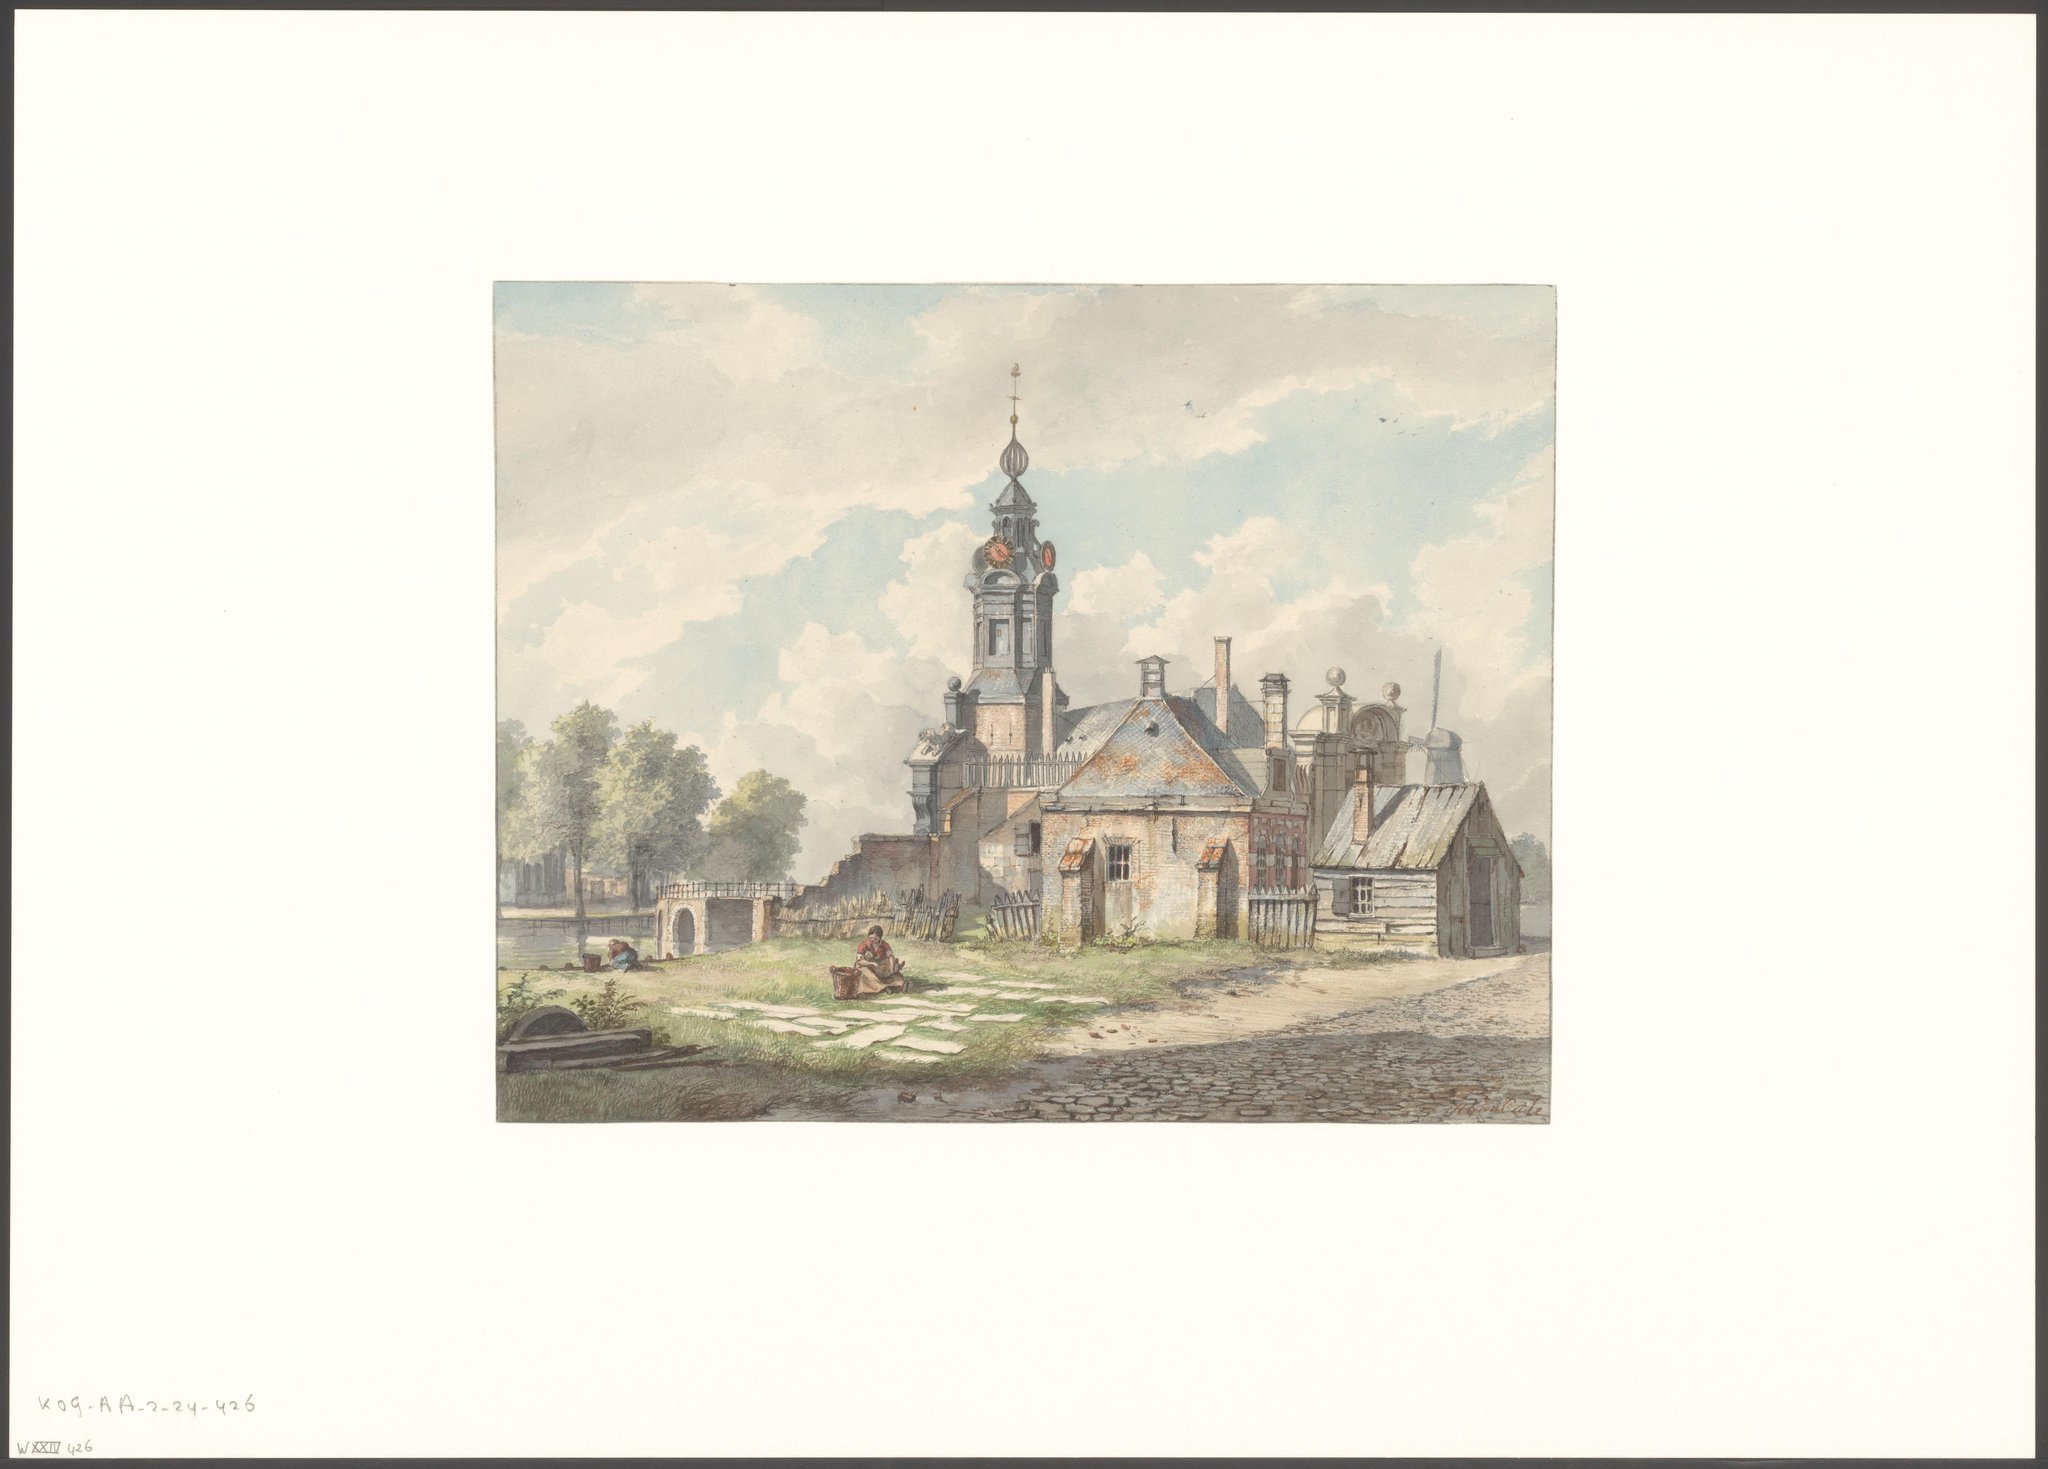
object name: drawing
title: Gezicht op de Haarlemmerpoort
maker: hendrik gerrit ten cate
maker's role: draughtsman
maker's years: 1803-1856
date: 1813-1856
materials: chalk, paper, watercolor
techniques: brush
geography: amsterdam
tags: city-view in general; 'veduta', canal, bridge in city across river, canal, etc., city-gate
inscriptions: collector's mark: Lugt 800a, inscription: ‘H.L.R. / 35’, signature: ‘HG ten Cate’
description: Tekening binnen de Atlas Van Eck ingedeeld op wijknummer 24.